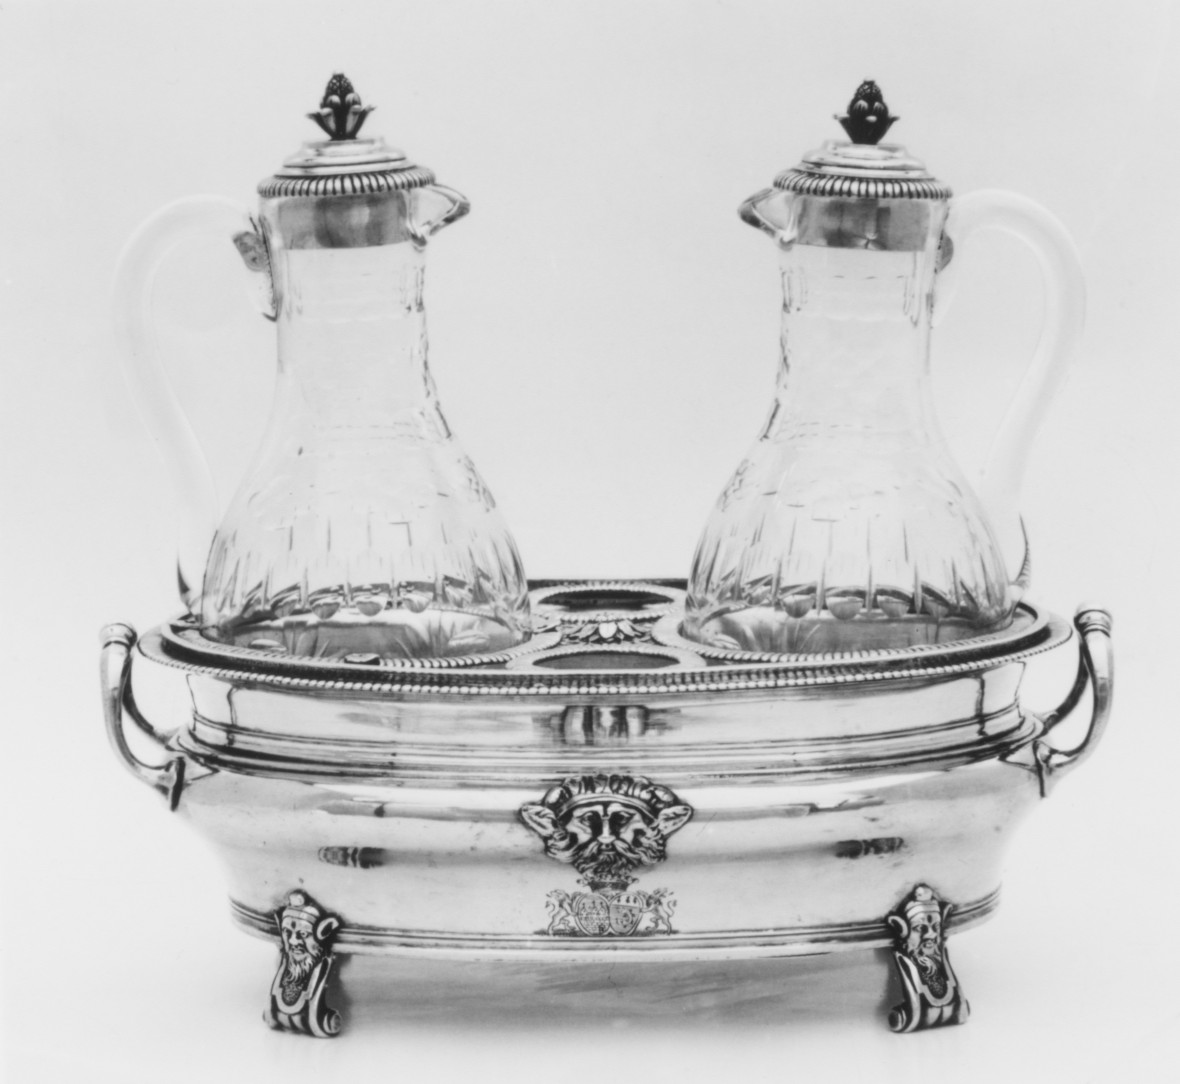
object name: cruet frame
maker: pierre-noel david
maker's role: maker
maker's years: 1699-1759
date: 1730-1735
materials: glass, silver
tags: coat of arms